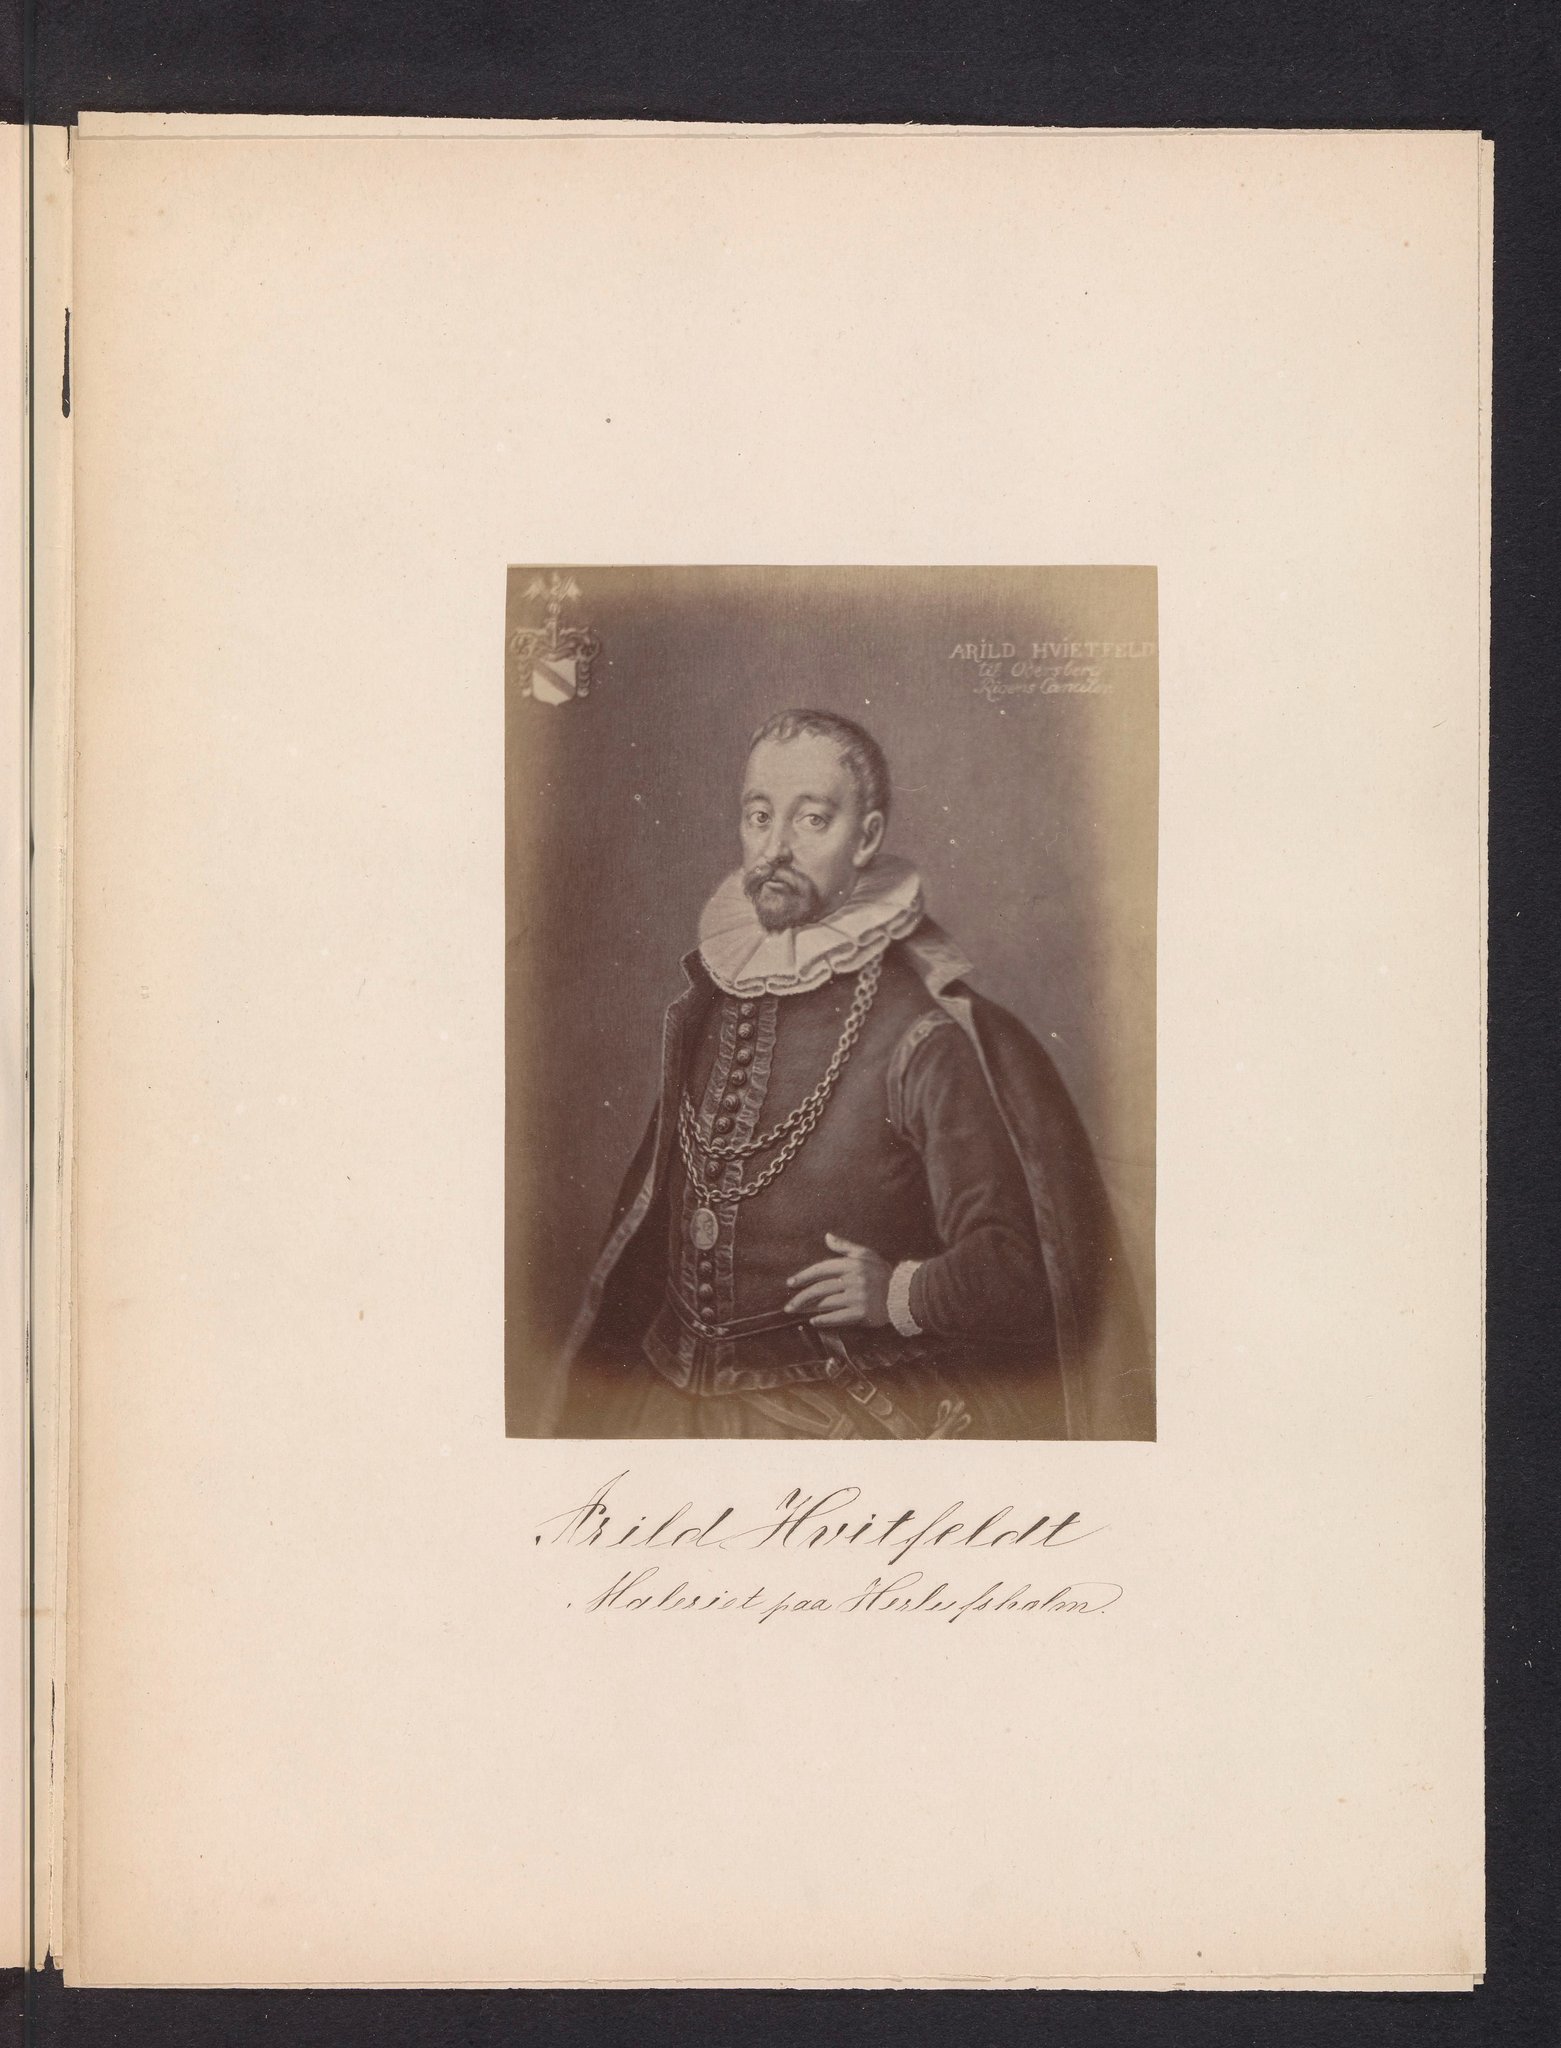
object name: photograph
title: Arild Huitfeldt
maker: julius wulff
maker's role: fotograaf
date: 1858-1862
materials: photographic support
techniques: albumen print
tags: portrait of a writer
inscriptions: inscription: ‘Maleriet paa [...]’